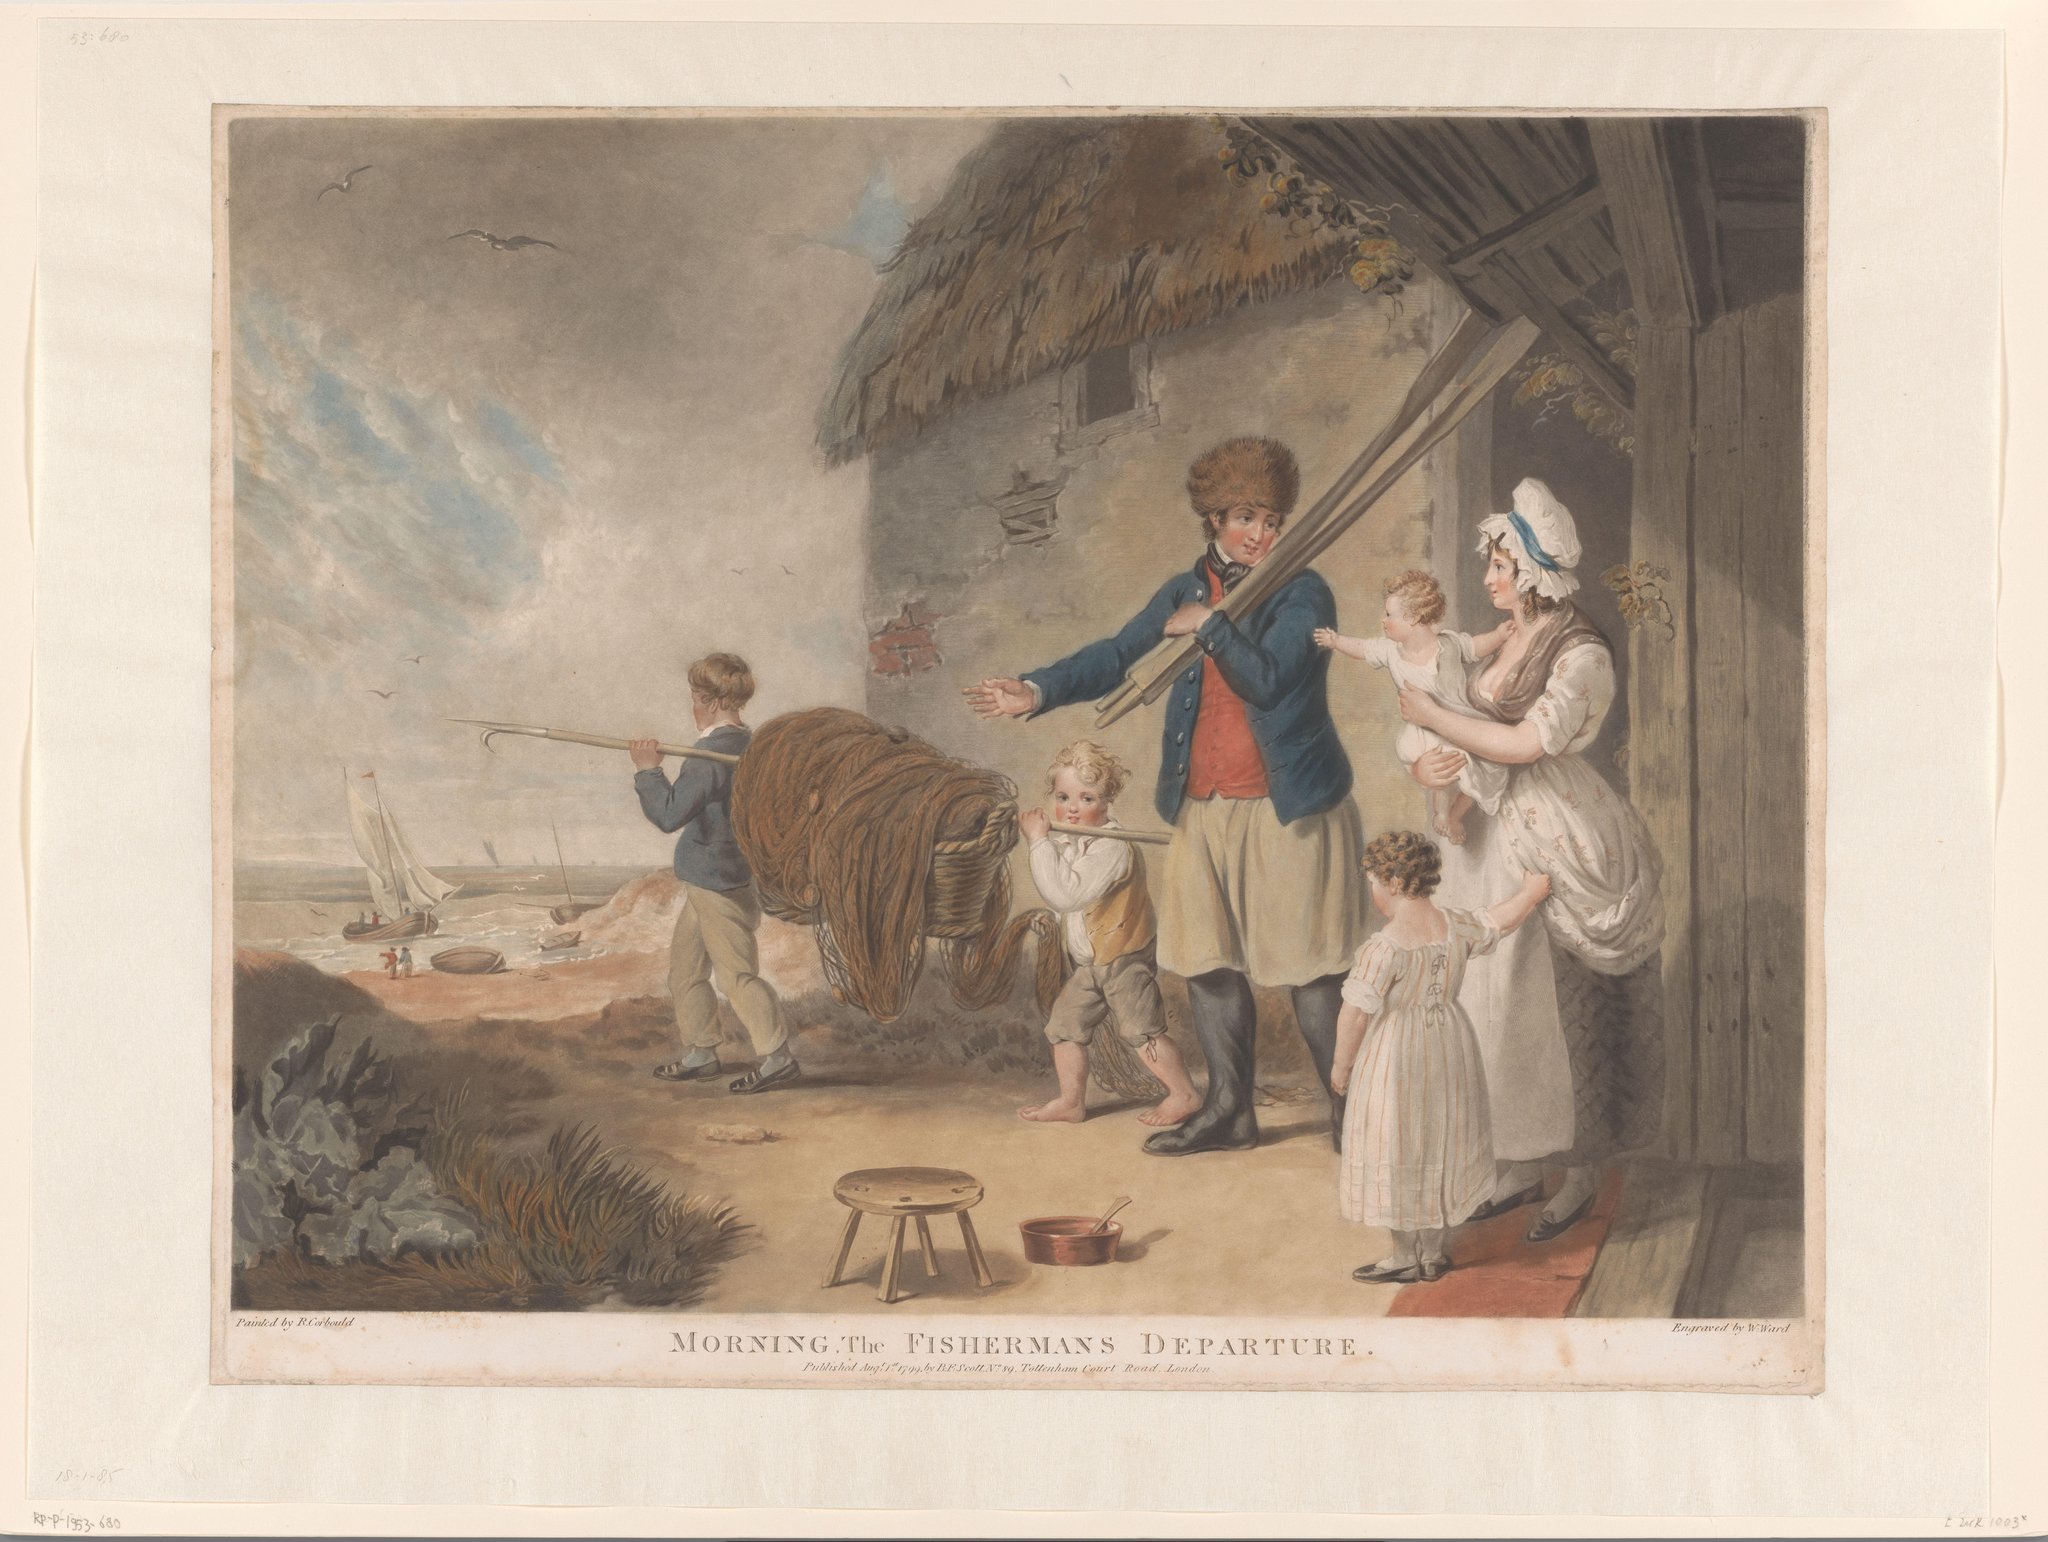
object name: print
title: Morning, The Fishermans Departure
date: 1799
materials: paper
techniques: hand coloring, lithography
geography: london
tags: family life at home, departure ~ travelling, fisherman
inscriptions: collector's mark: Lugt 2228